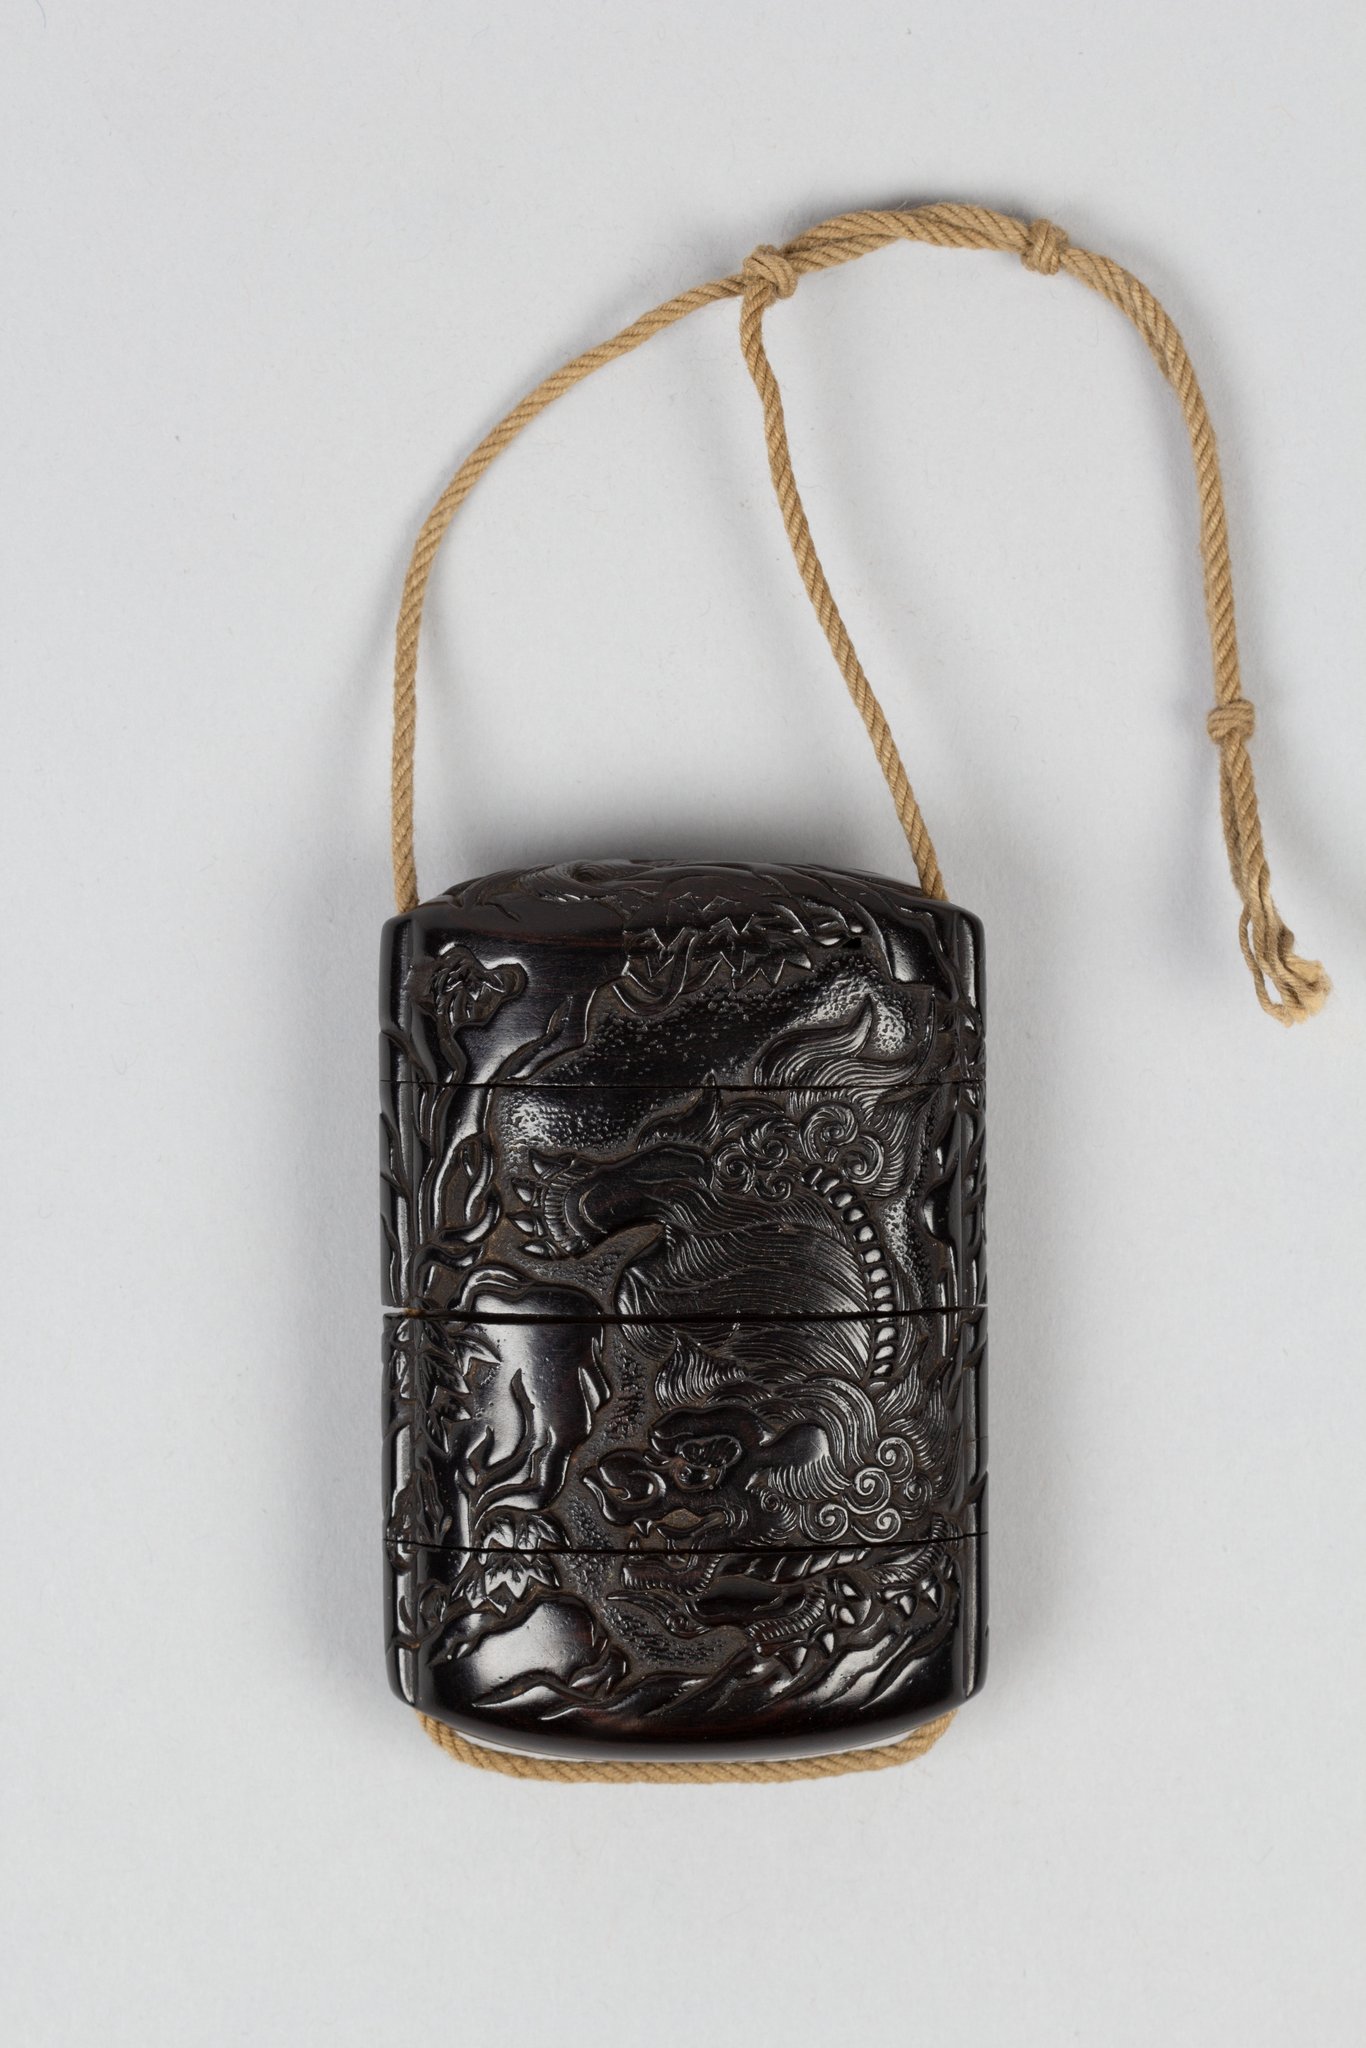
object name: inrō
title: Case (Inrō) with Design of Shishi Dog Jumping and Climbing among Rocks and Bamboo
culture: japanese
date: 1801-1900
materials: wood, metal, silver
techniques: carving, lining, relief